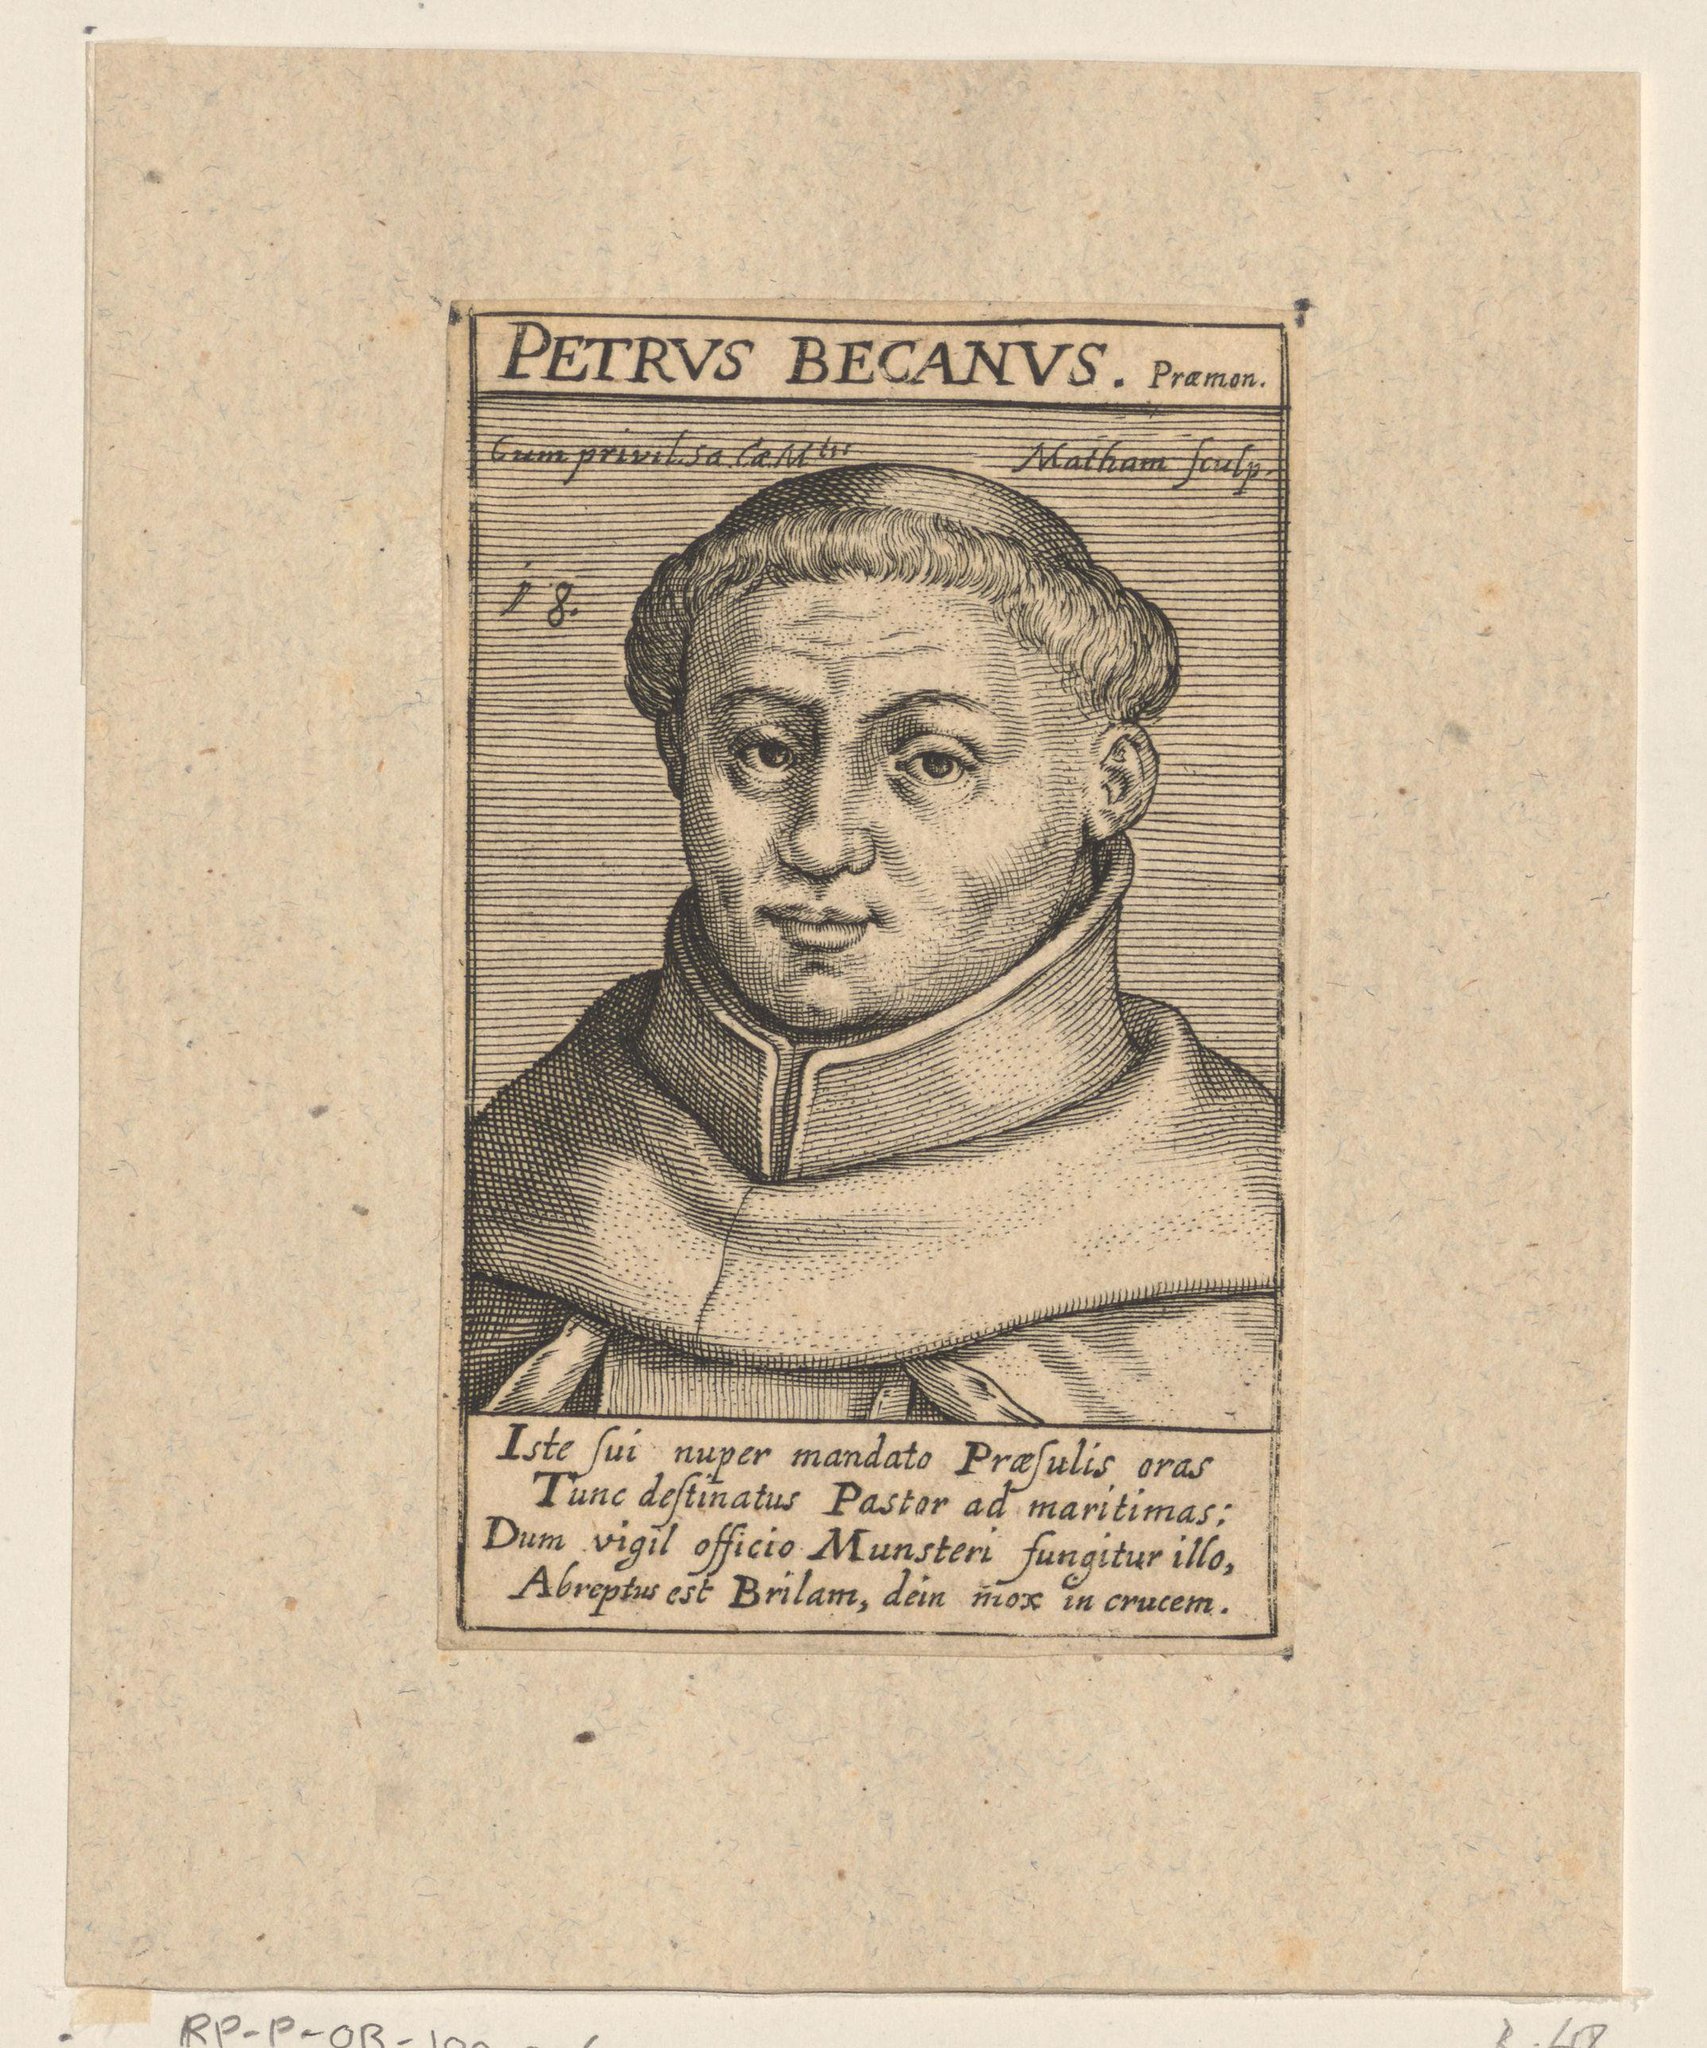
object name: print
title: De martelaren van Gorcum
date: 1617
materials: paper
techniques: engraving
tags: brielle, historical persons, monk(s), friar(s)